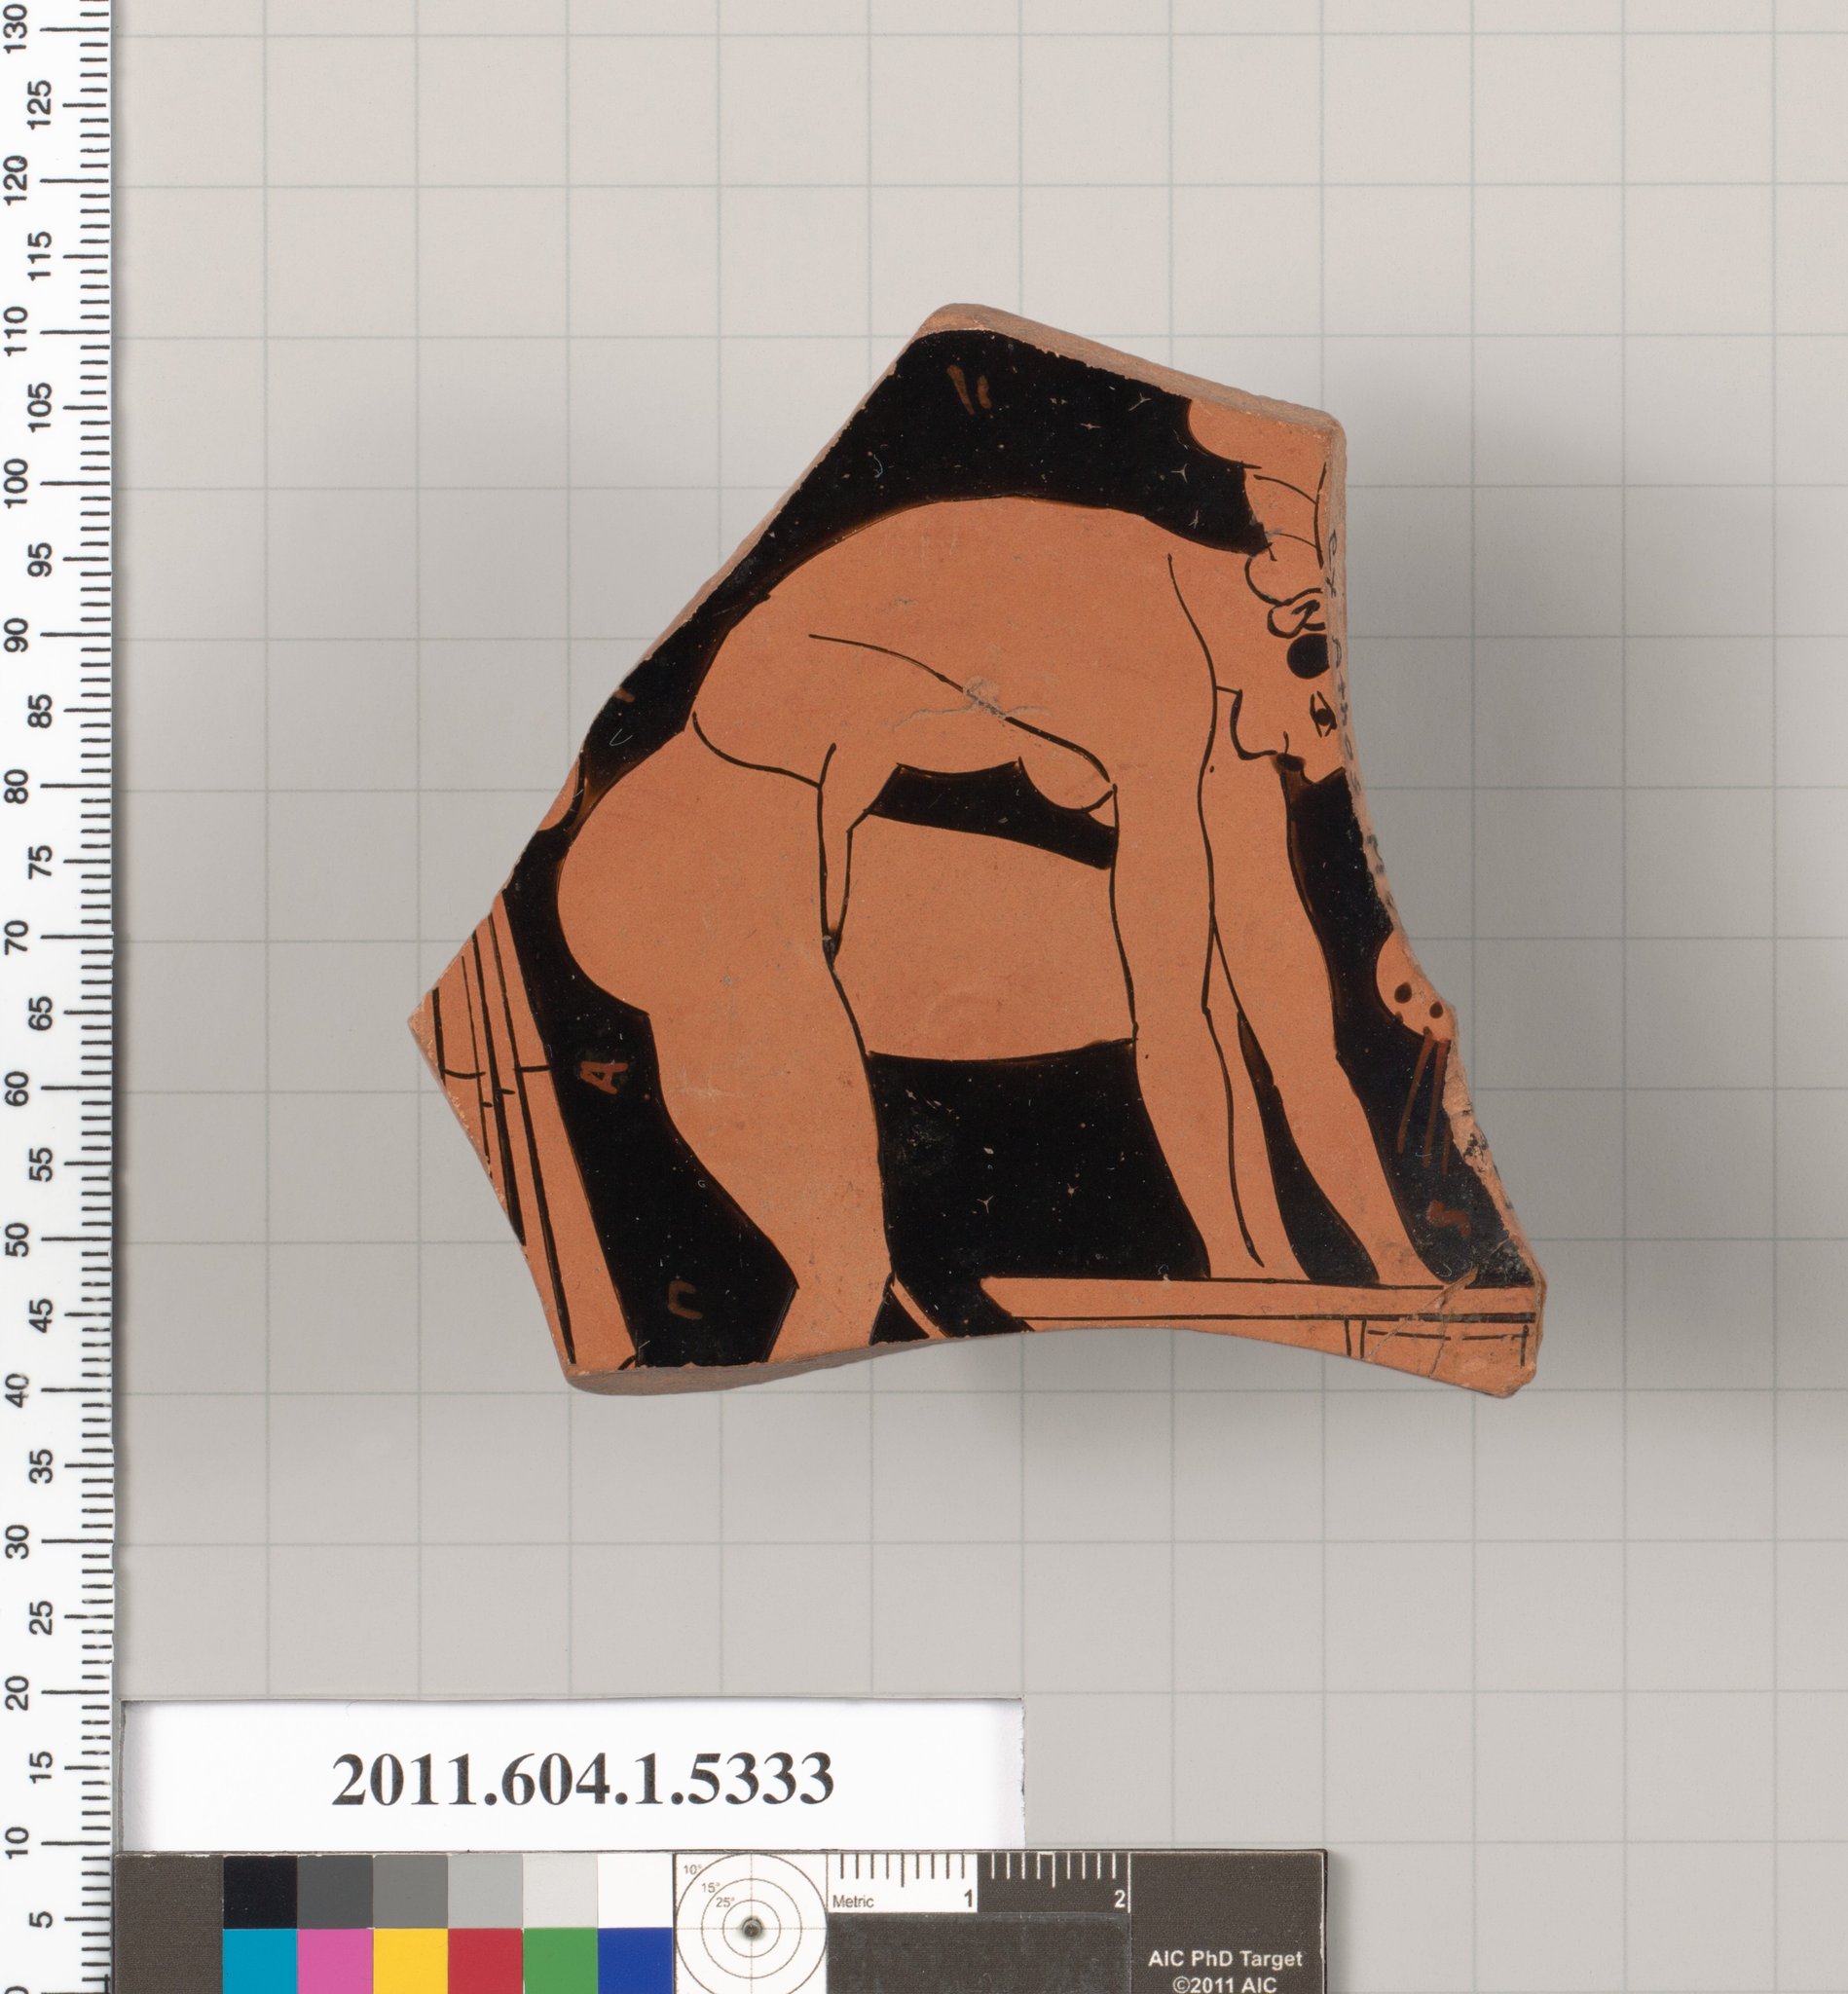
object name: kylix fragment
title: Terracotta fragment of a kylix (drinking cup)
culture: greek, attic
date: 510-490 BCE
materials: terracotta